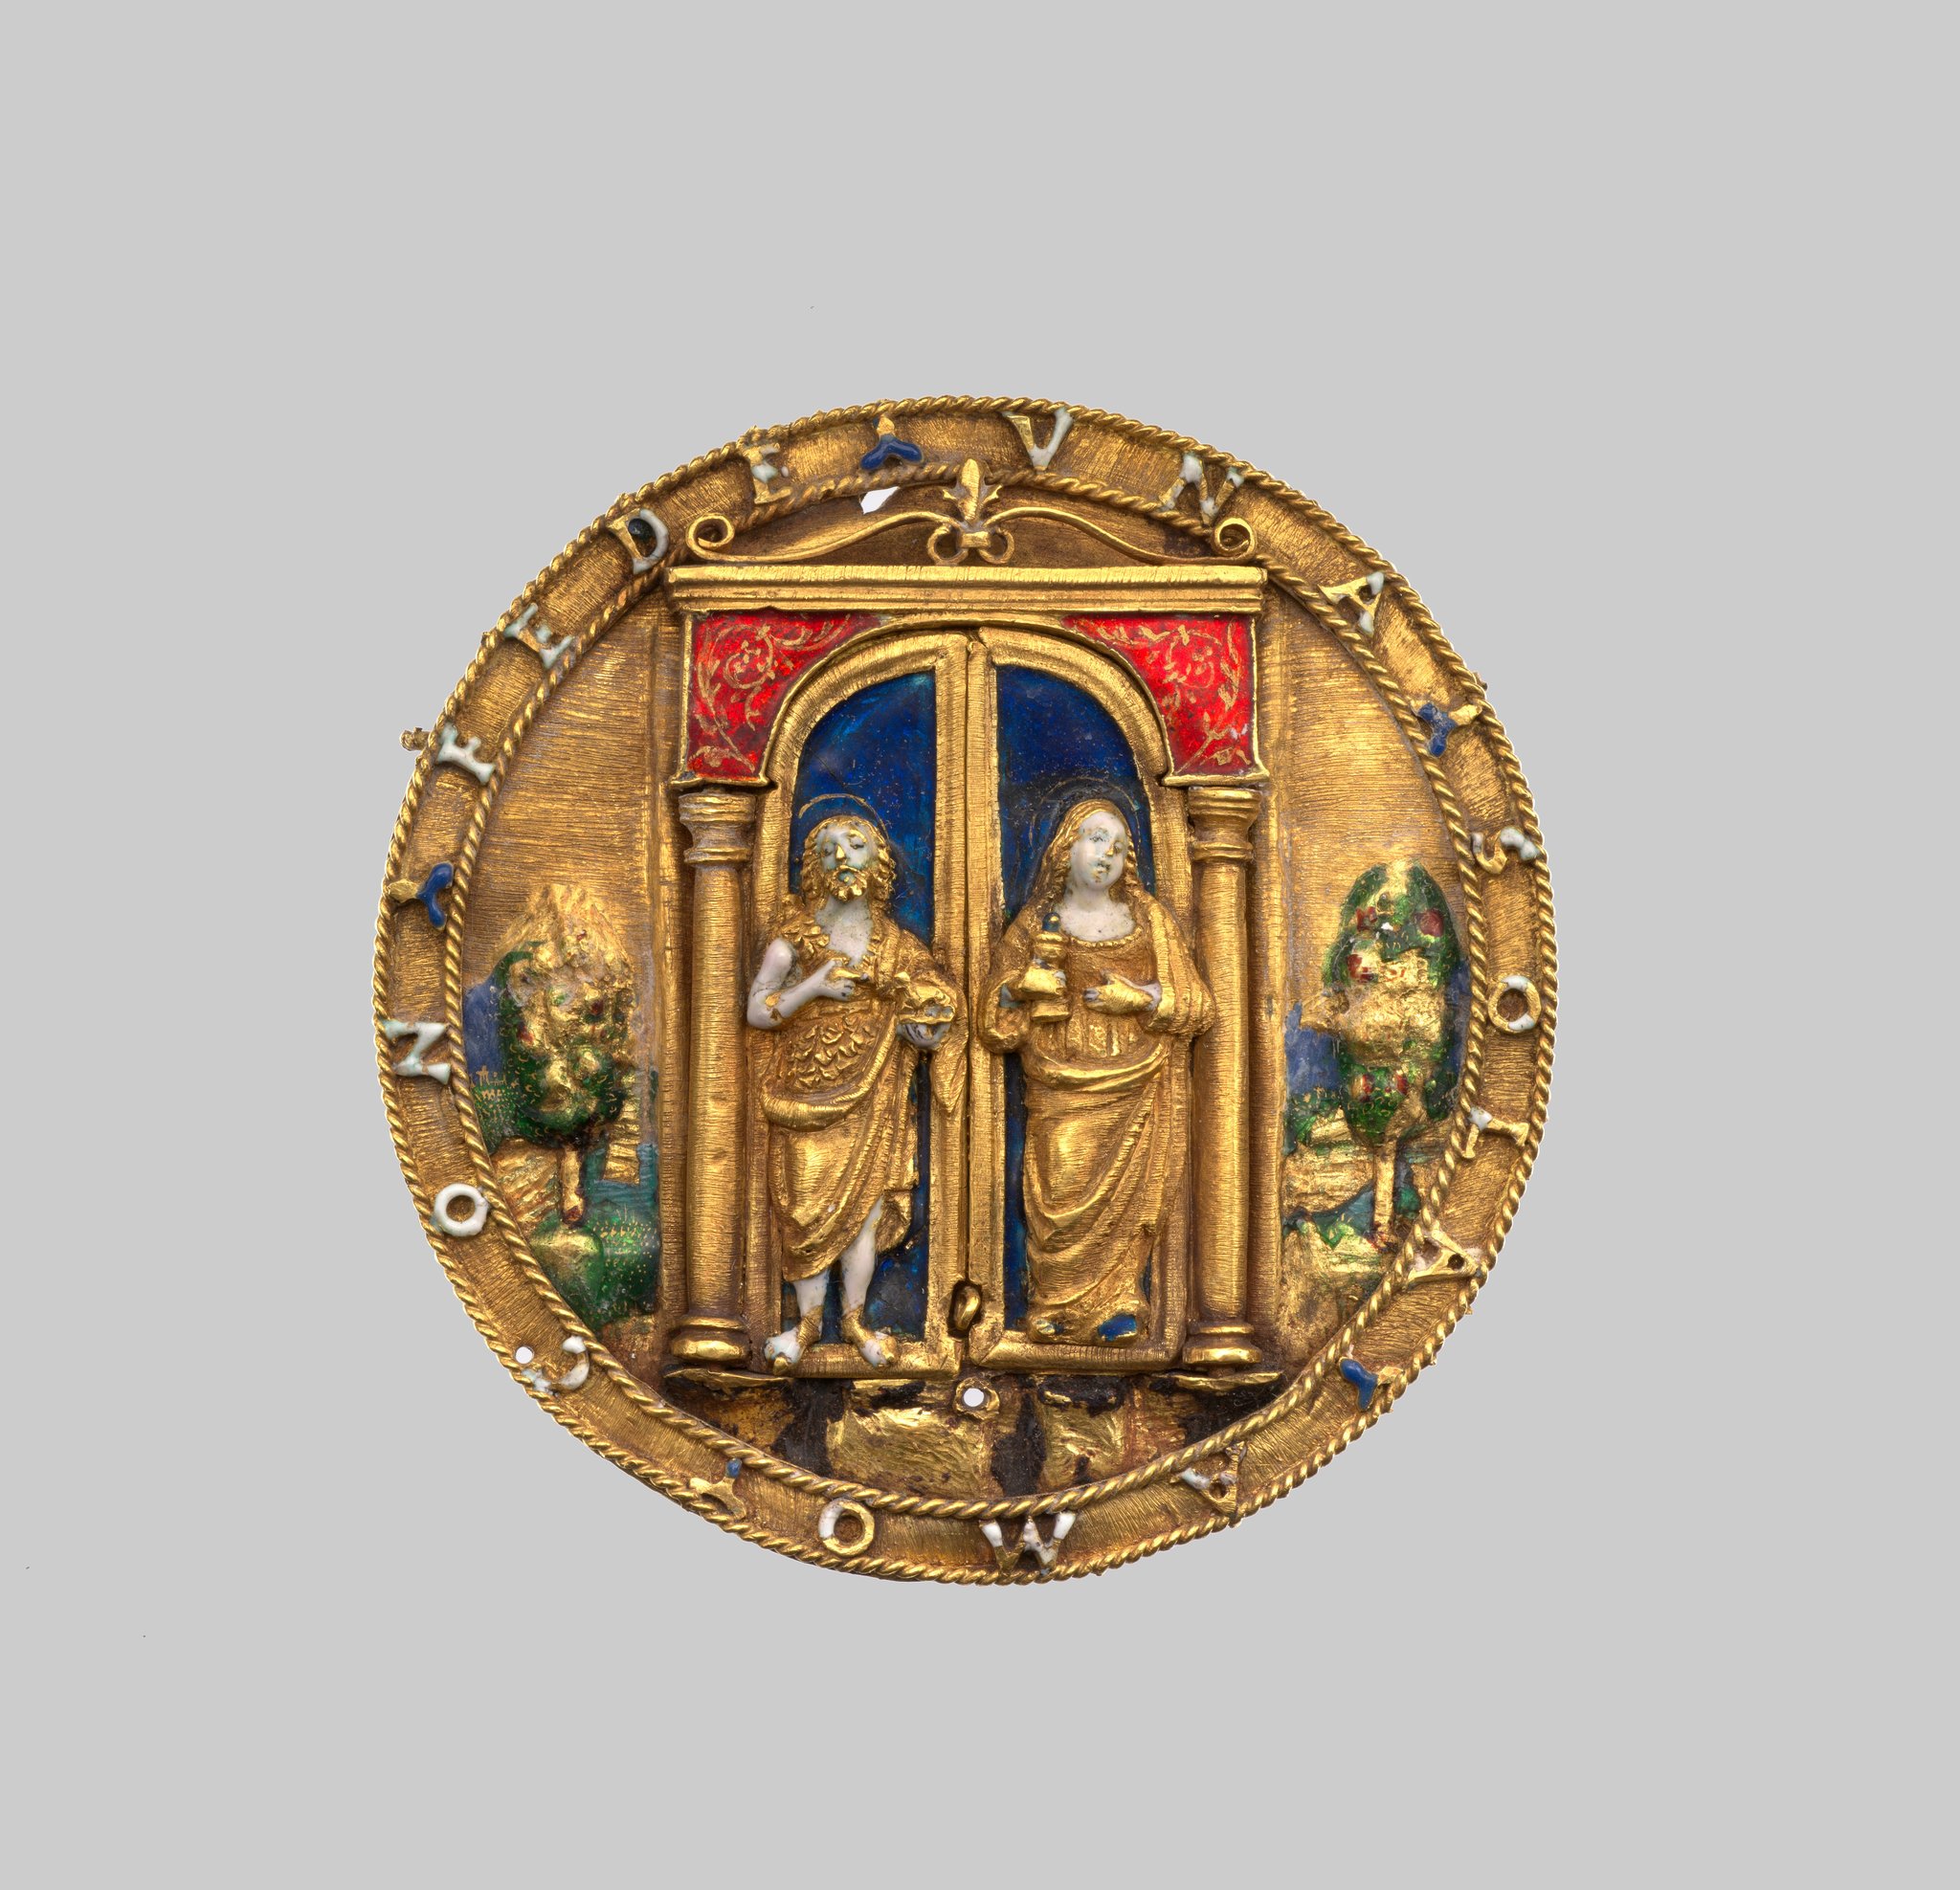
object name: hat badge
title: Veronica's Veil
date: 1467-1500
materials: gold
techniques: enamel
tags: saint john the baptist,saint john the evangelist,archangel gabriel